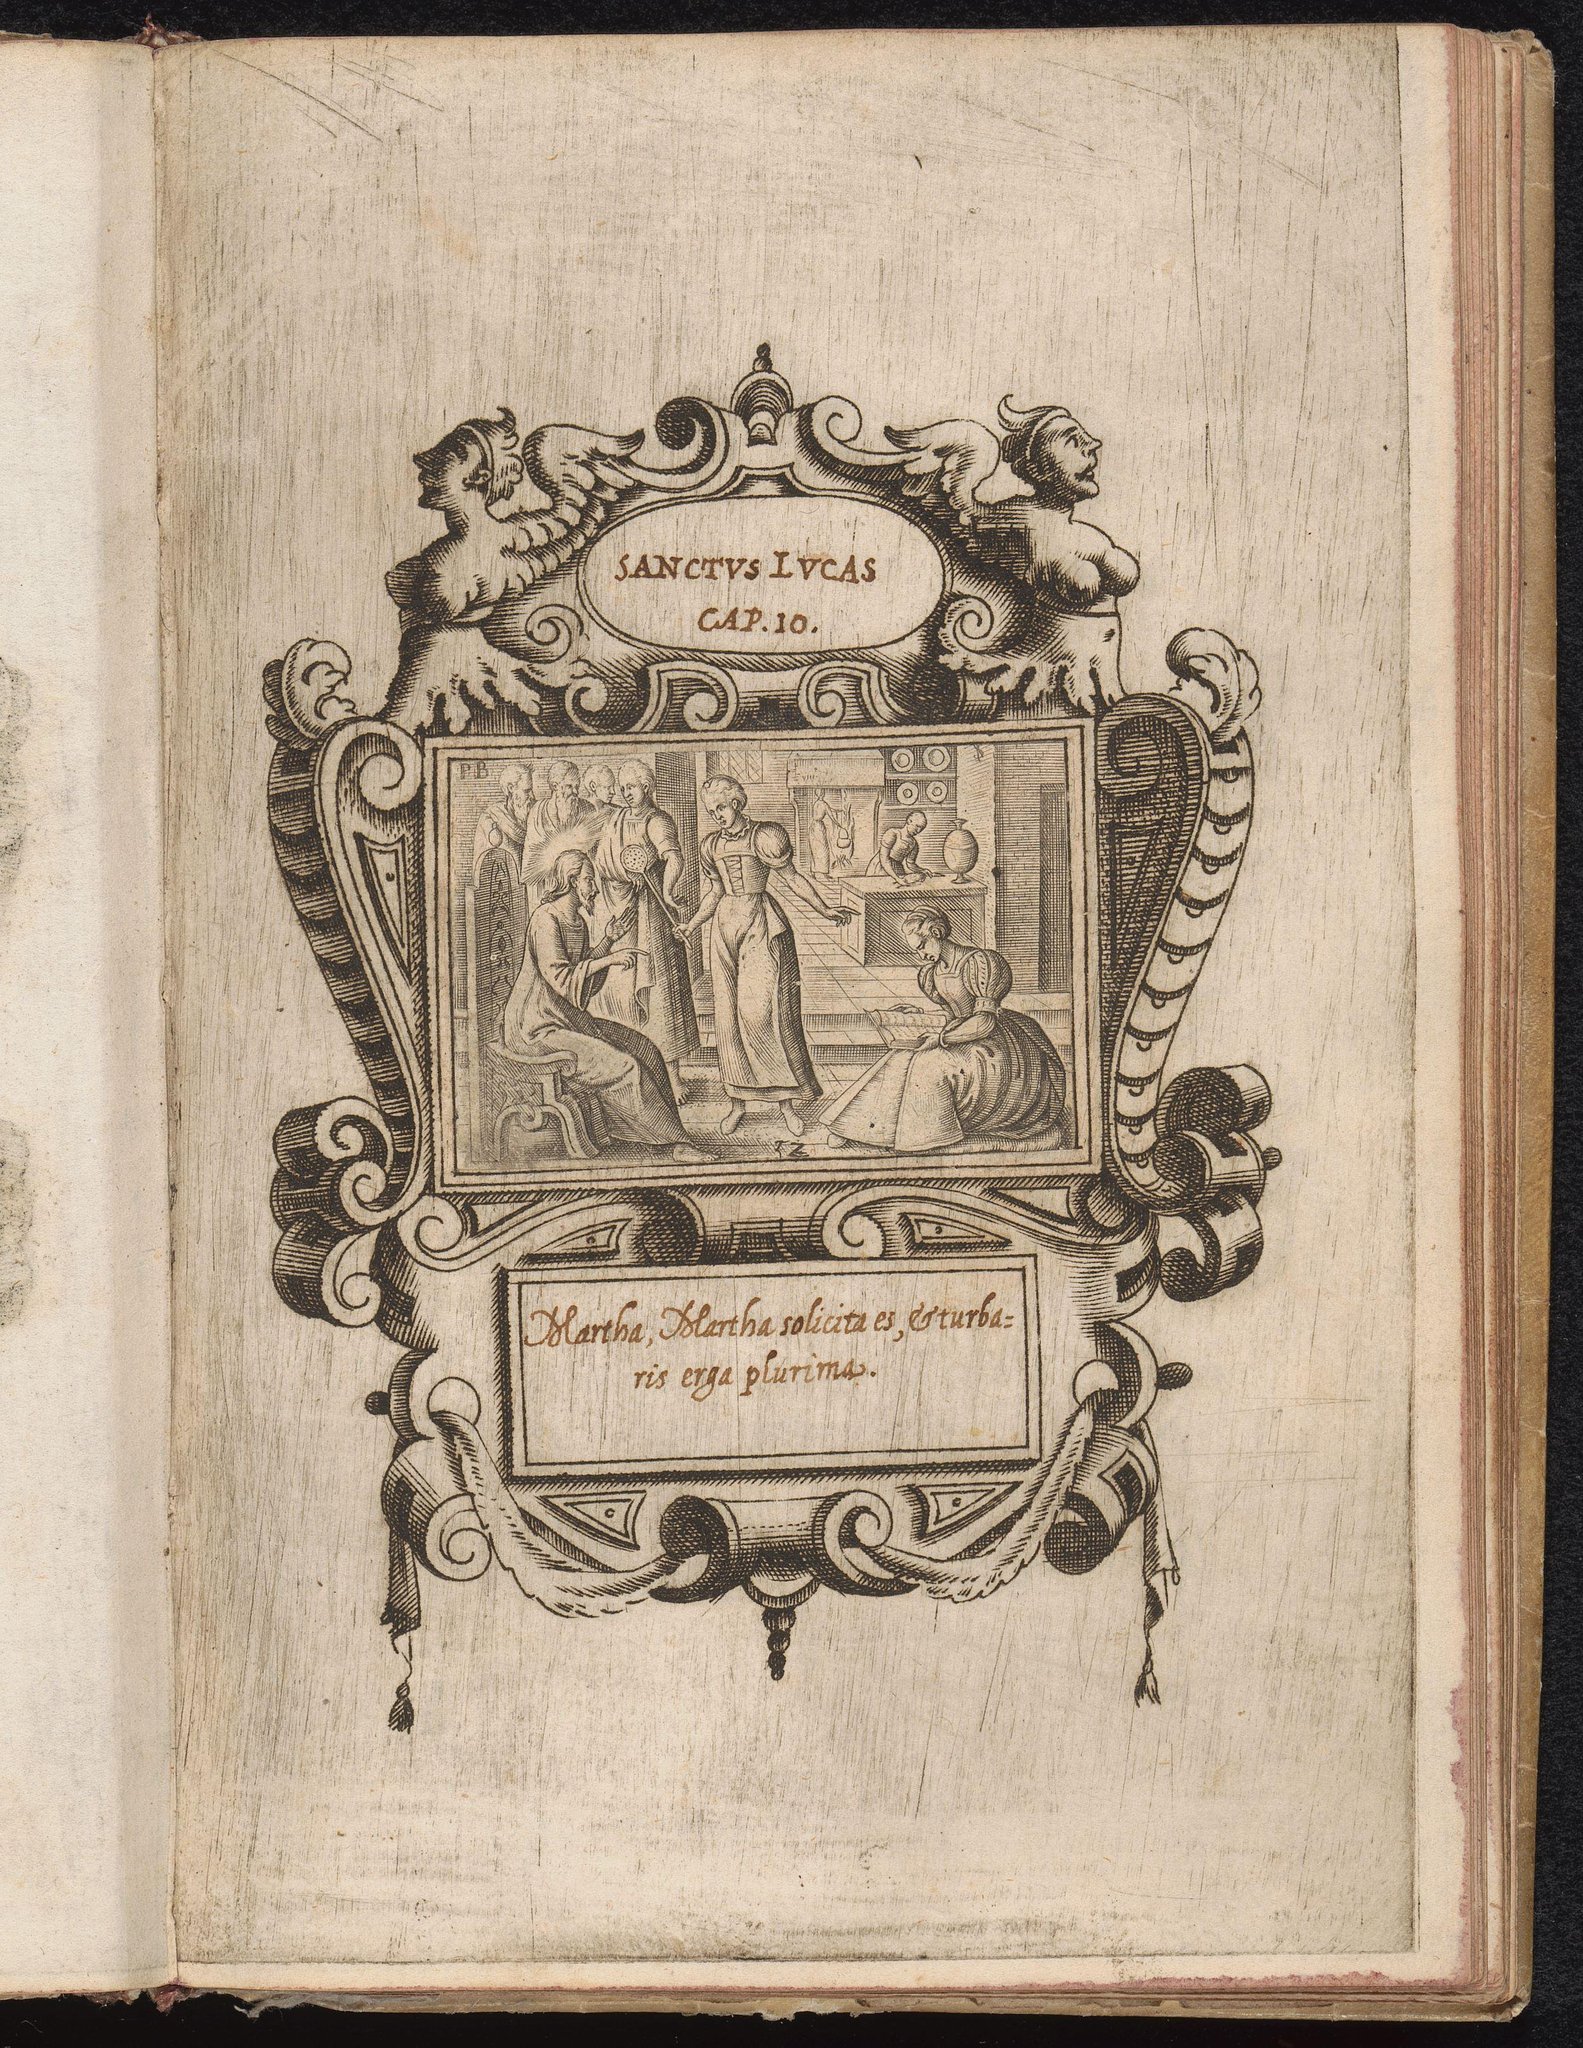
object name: print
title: Christus in het huis van Marta en Maria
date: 1570-1610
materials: paper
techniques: engraving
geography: antwerp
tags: christ in the house of martha and mary (luke 10:38-42)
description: Christus in het huis van Marta en Maria. Onderdeel van een prentalbum met titelprent en 56 scènes uit het Nieuwe Testament. Elke voorstelling gemonteerd in een gravure met ornamentele cartouches waarin een venster is gesneden en voorzien van handgeschreven bijbelpassages.